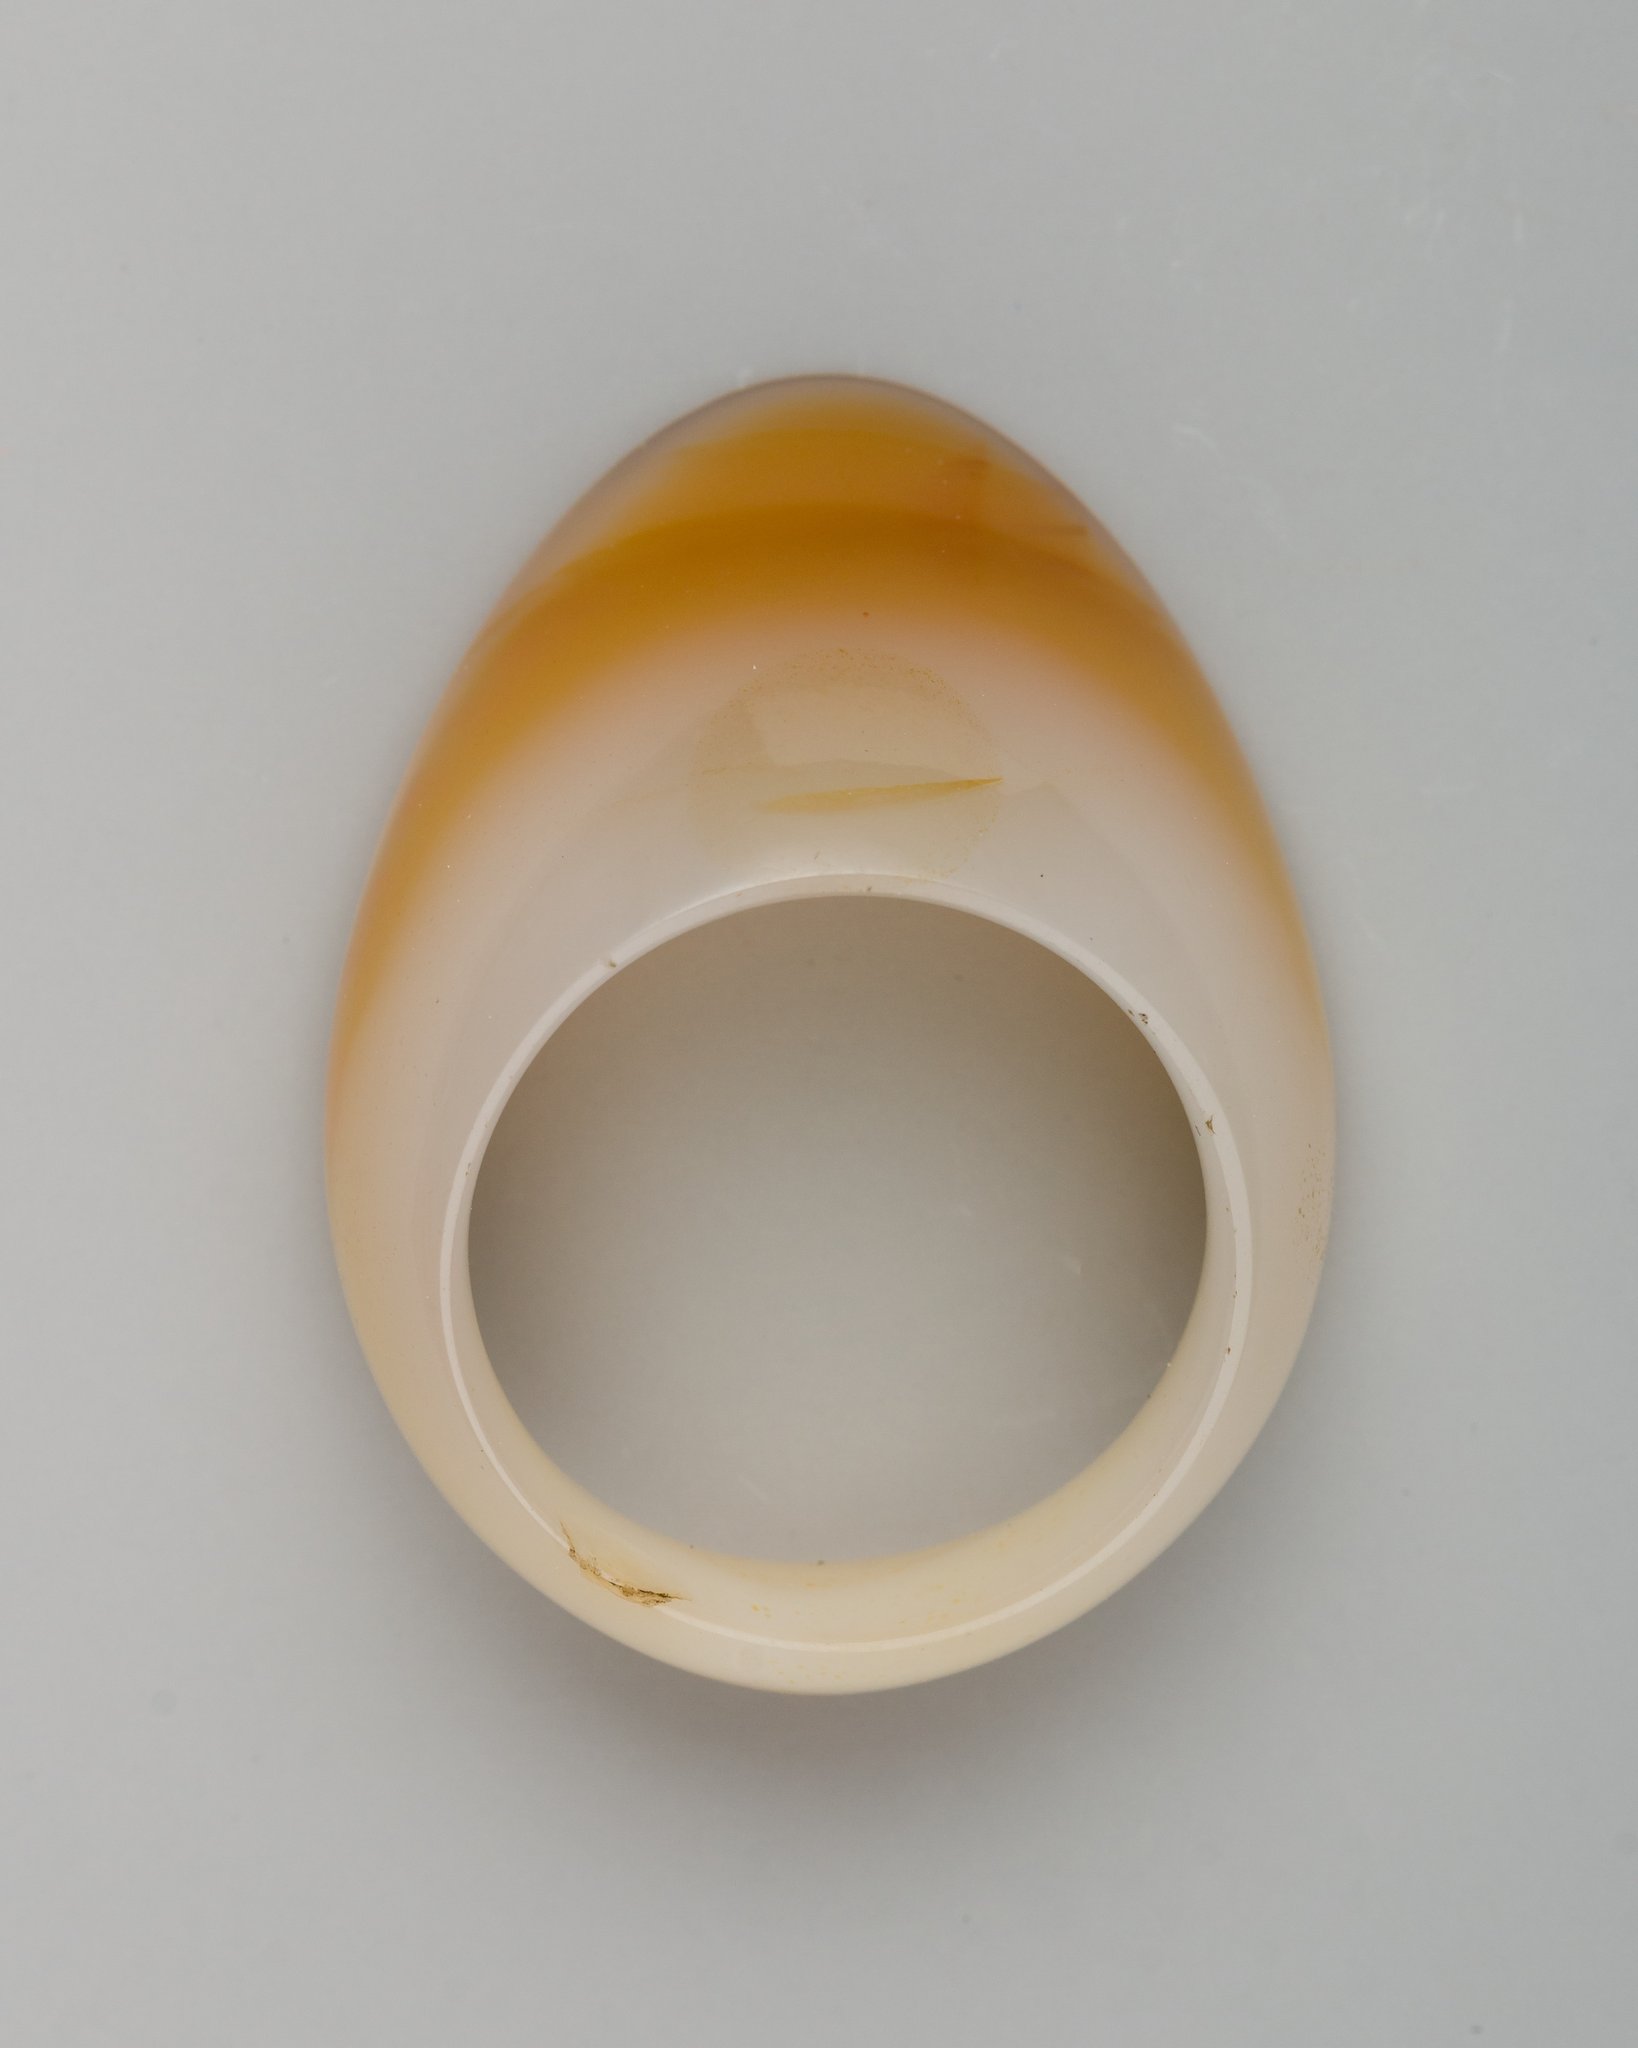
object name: archer's ring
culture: indian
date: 1701-1800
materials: stone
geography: india